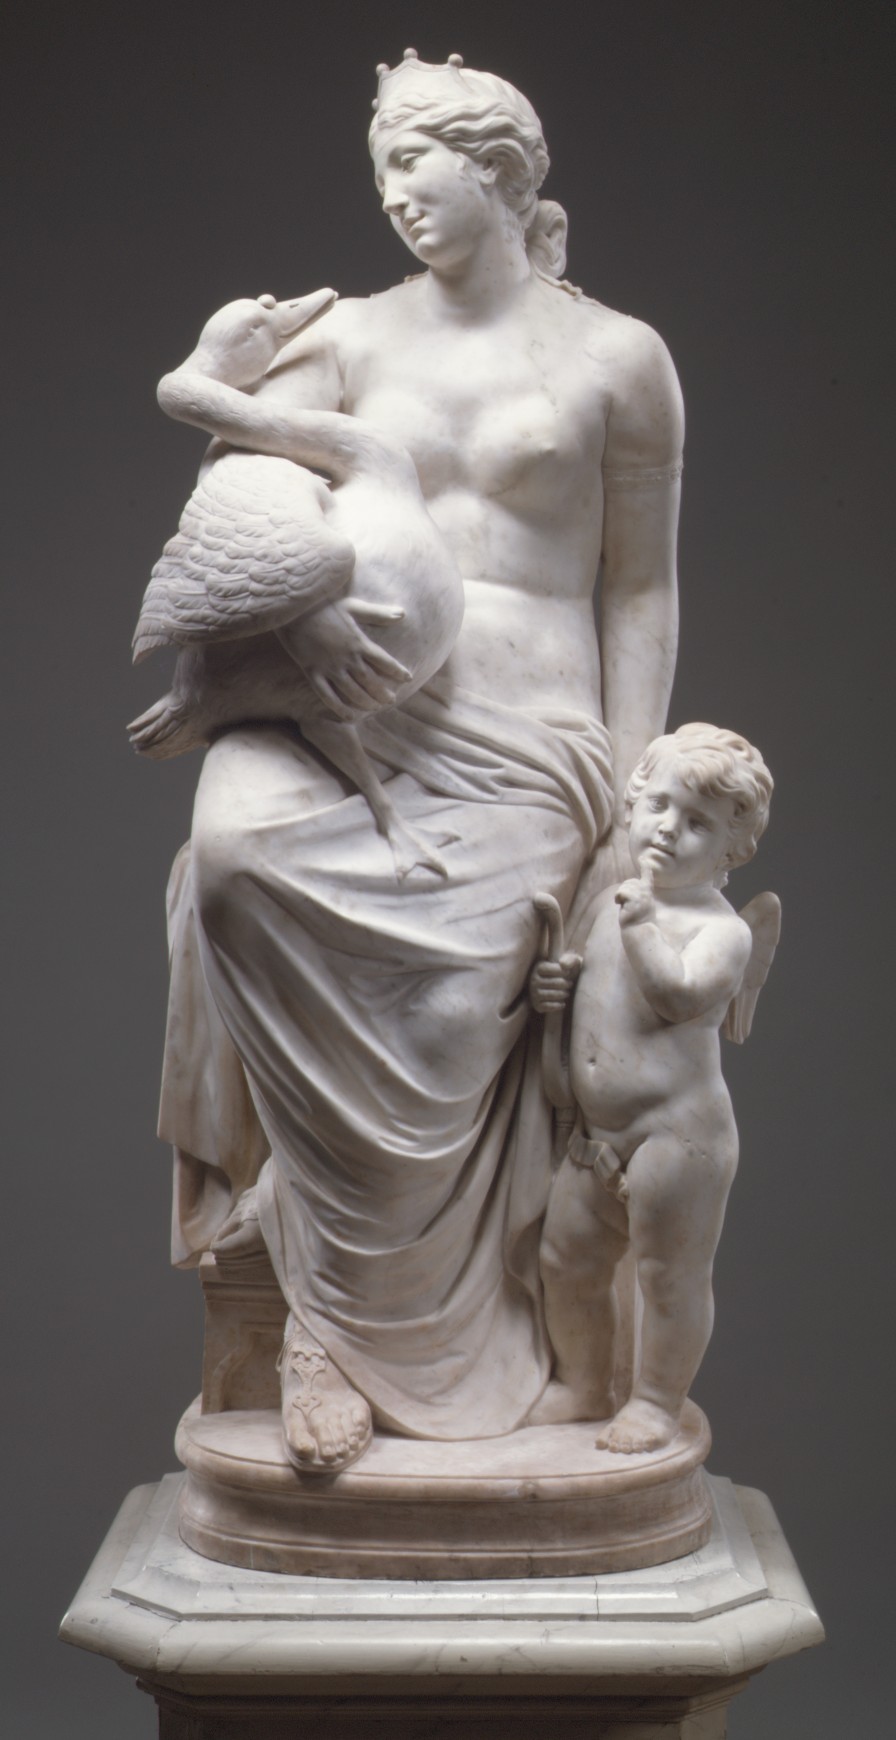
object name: group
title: Leda and the Swan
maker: jacques sarazin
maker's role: artist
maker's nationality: french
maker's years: 1592-1660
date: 1640-1650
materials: marble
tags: cupid,leda,swans